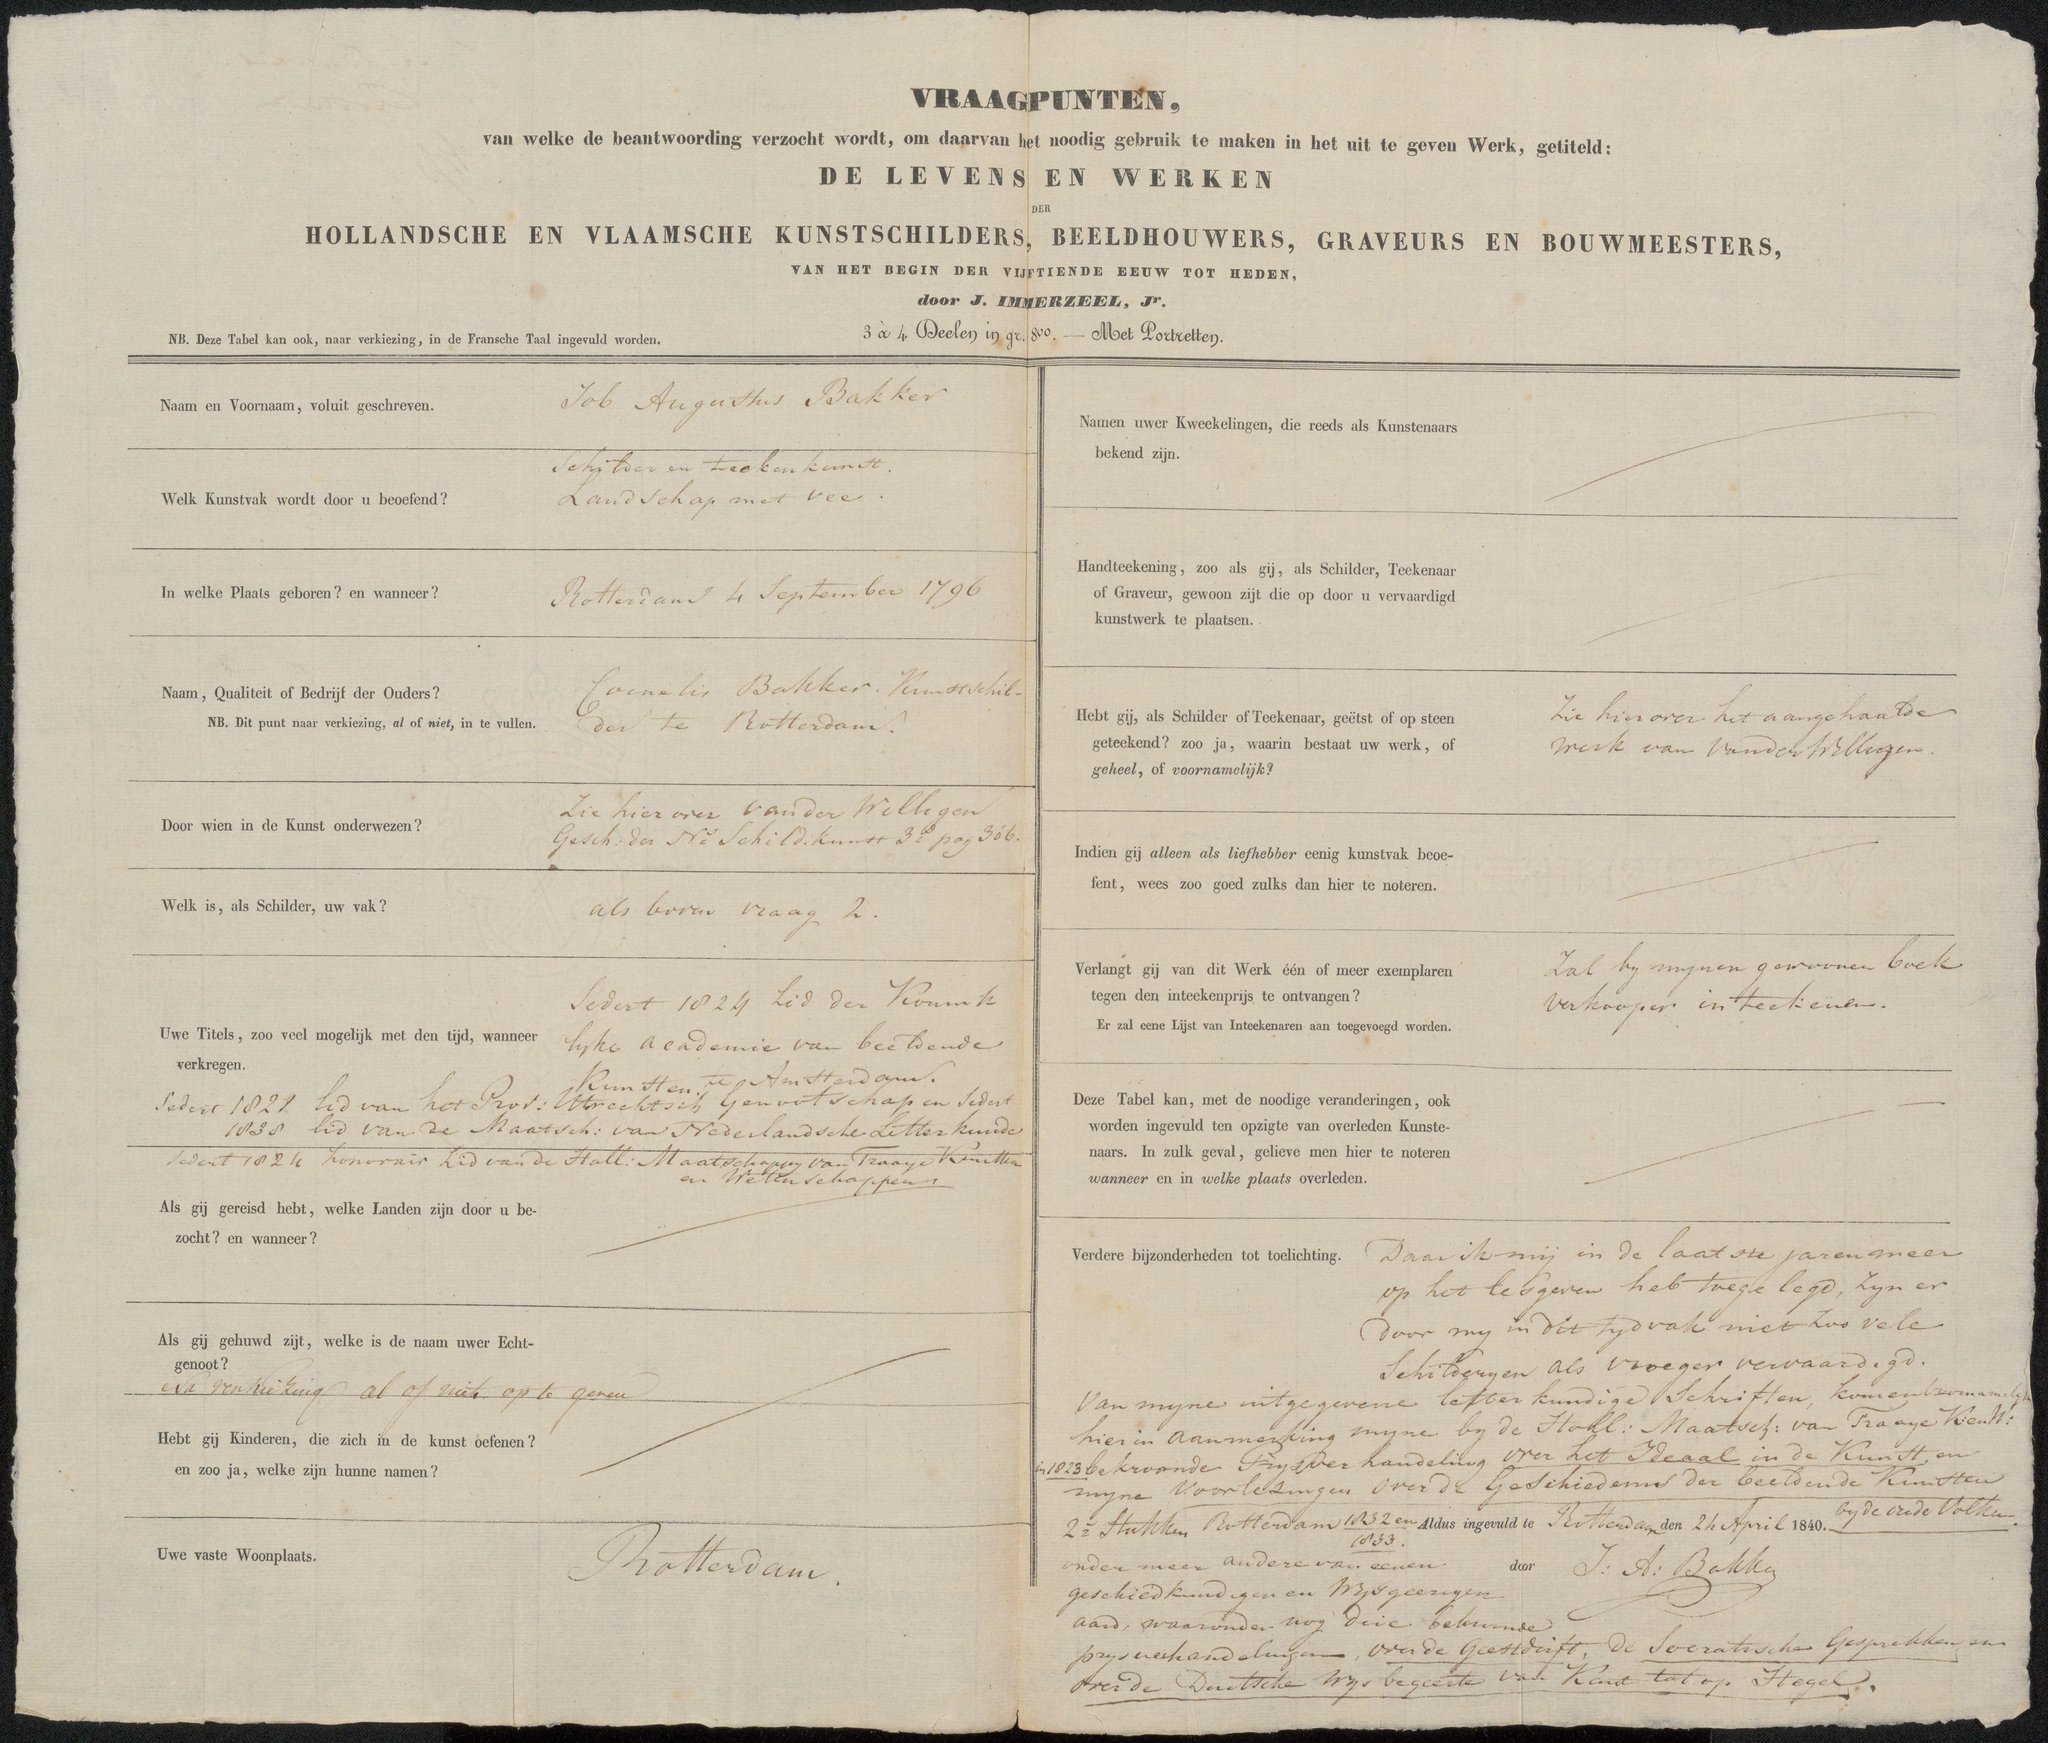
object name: manuscript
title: Enquêteformulier ingevuld door Job Augustus Bakker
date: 1840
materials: ink, paper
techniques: pen, printing, writing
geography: rotterdam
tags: rotterdam, print maker, draughtsman, job augustus bakker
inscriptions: inscription: ‘Vraagpunten,/ van welke de beantwoording verzocht wordt, om daarvan het noodig gebruik te maken in het uit te geven Werk, getiteld: De levens en werken/ der Hollandsche en Vlaamsche kunstschilders, beeldhouwers,/ graveurs en bouwmeesters, van het begin der vijftiende eeuw tot heden/ door J. Immerzeel, Jr.’, watermark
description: Opgenomen in: Immerzeel, J. Jr., De levens en werken der Hollandsche en Vlaamsche kunstschilders, beeldhouwers, graveurs en bouwmeesters, van het begin der vijftiende eeuw tot heden, Amsterdam: J.C. van Kesteren, 1842-1843.